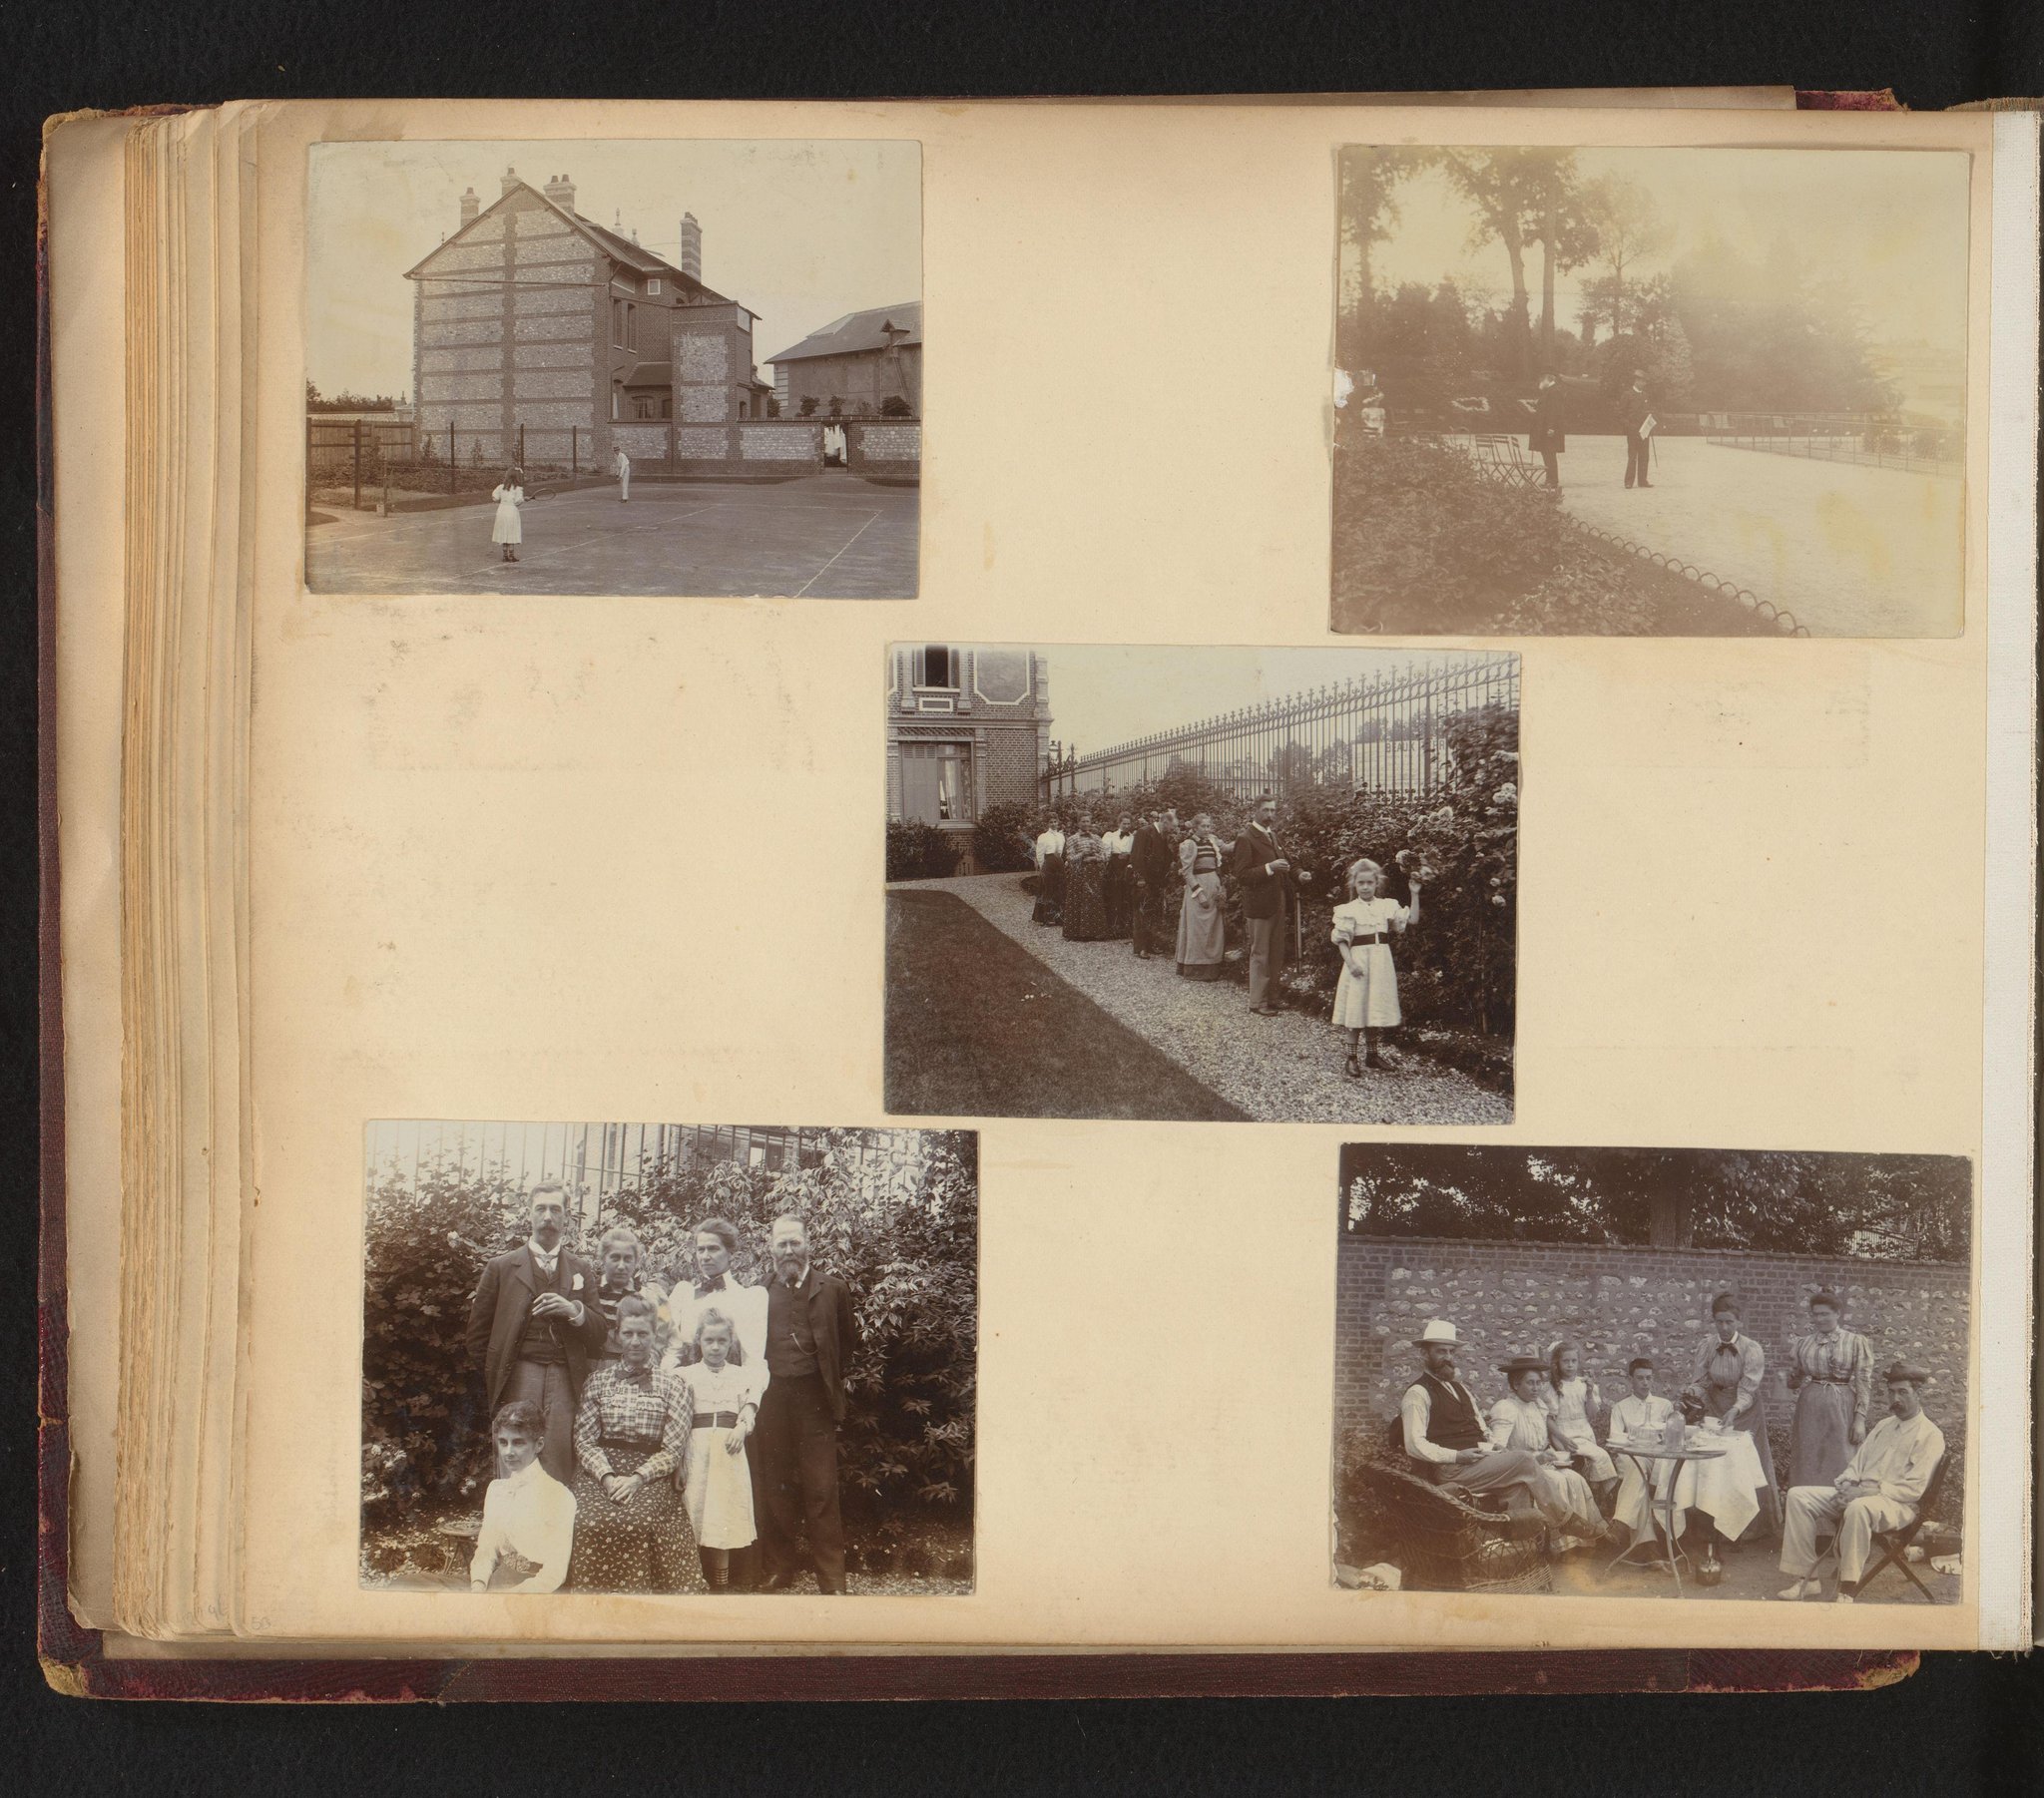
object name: album leaf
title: Diverse onderwerpen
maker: Anonymous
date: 1890-1898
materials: photographic support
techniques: gelatin silver print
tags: tennis, lawn-tennis, adult woman, garden, adult man, anonymous historical persons portrayed in a group, in a group-portrait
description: Groepsportretten in een tuin, tennissende personen en twee mannen in een tuin. Deze pagina maakt deel uit van een album.